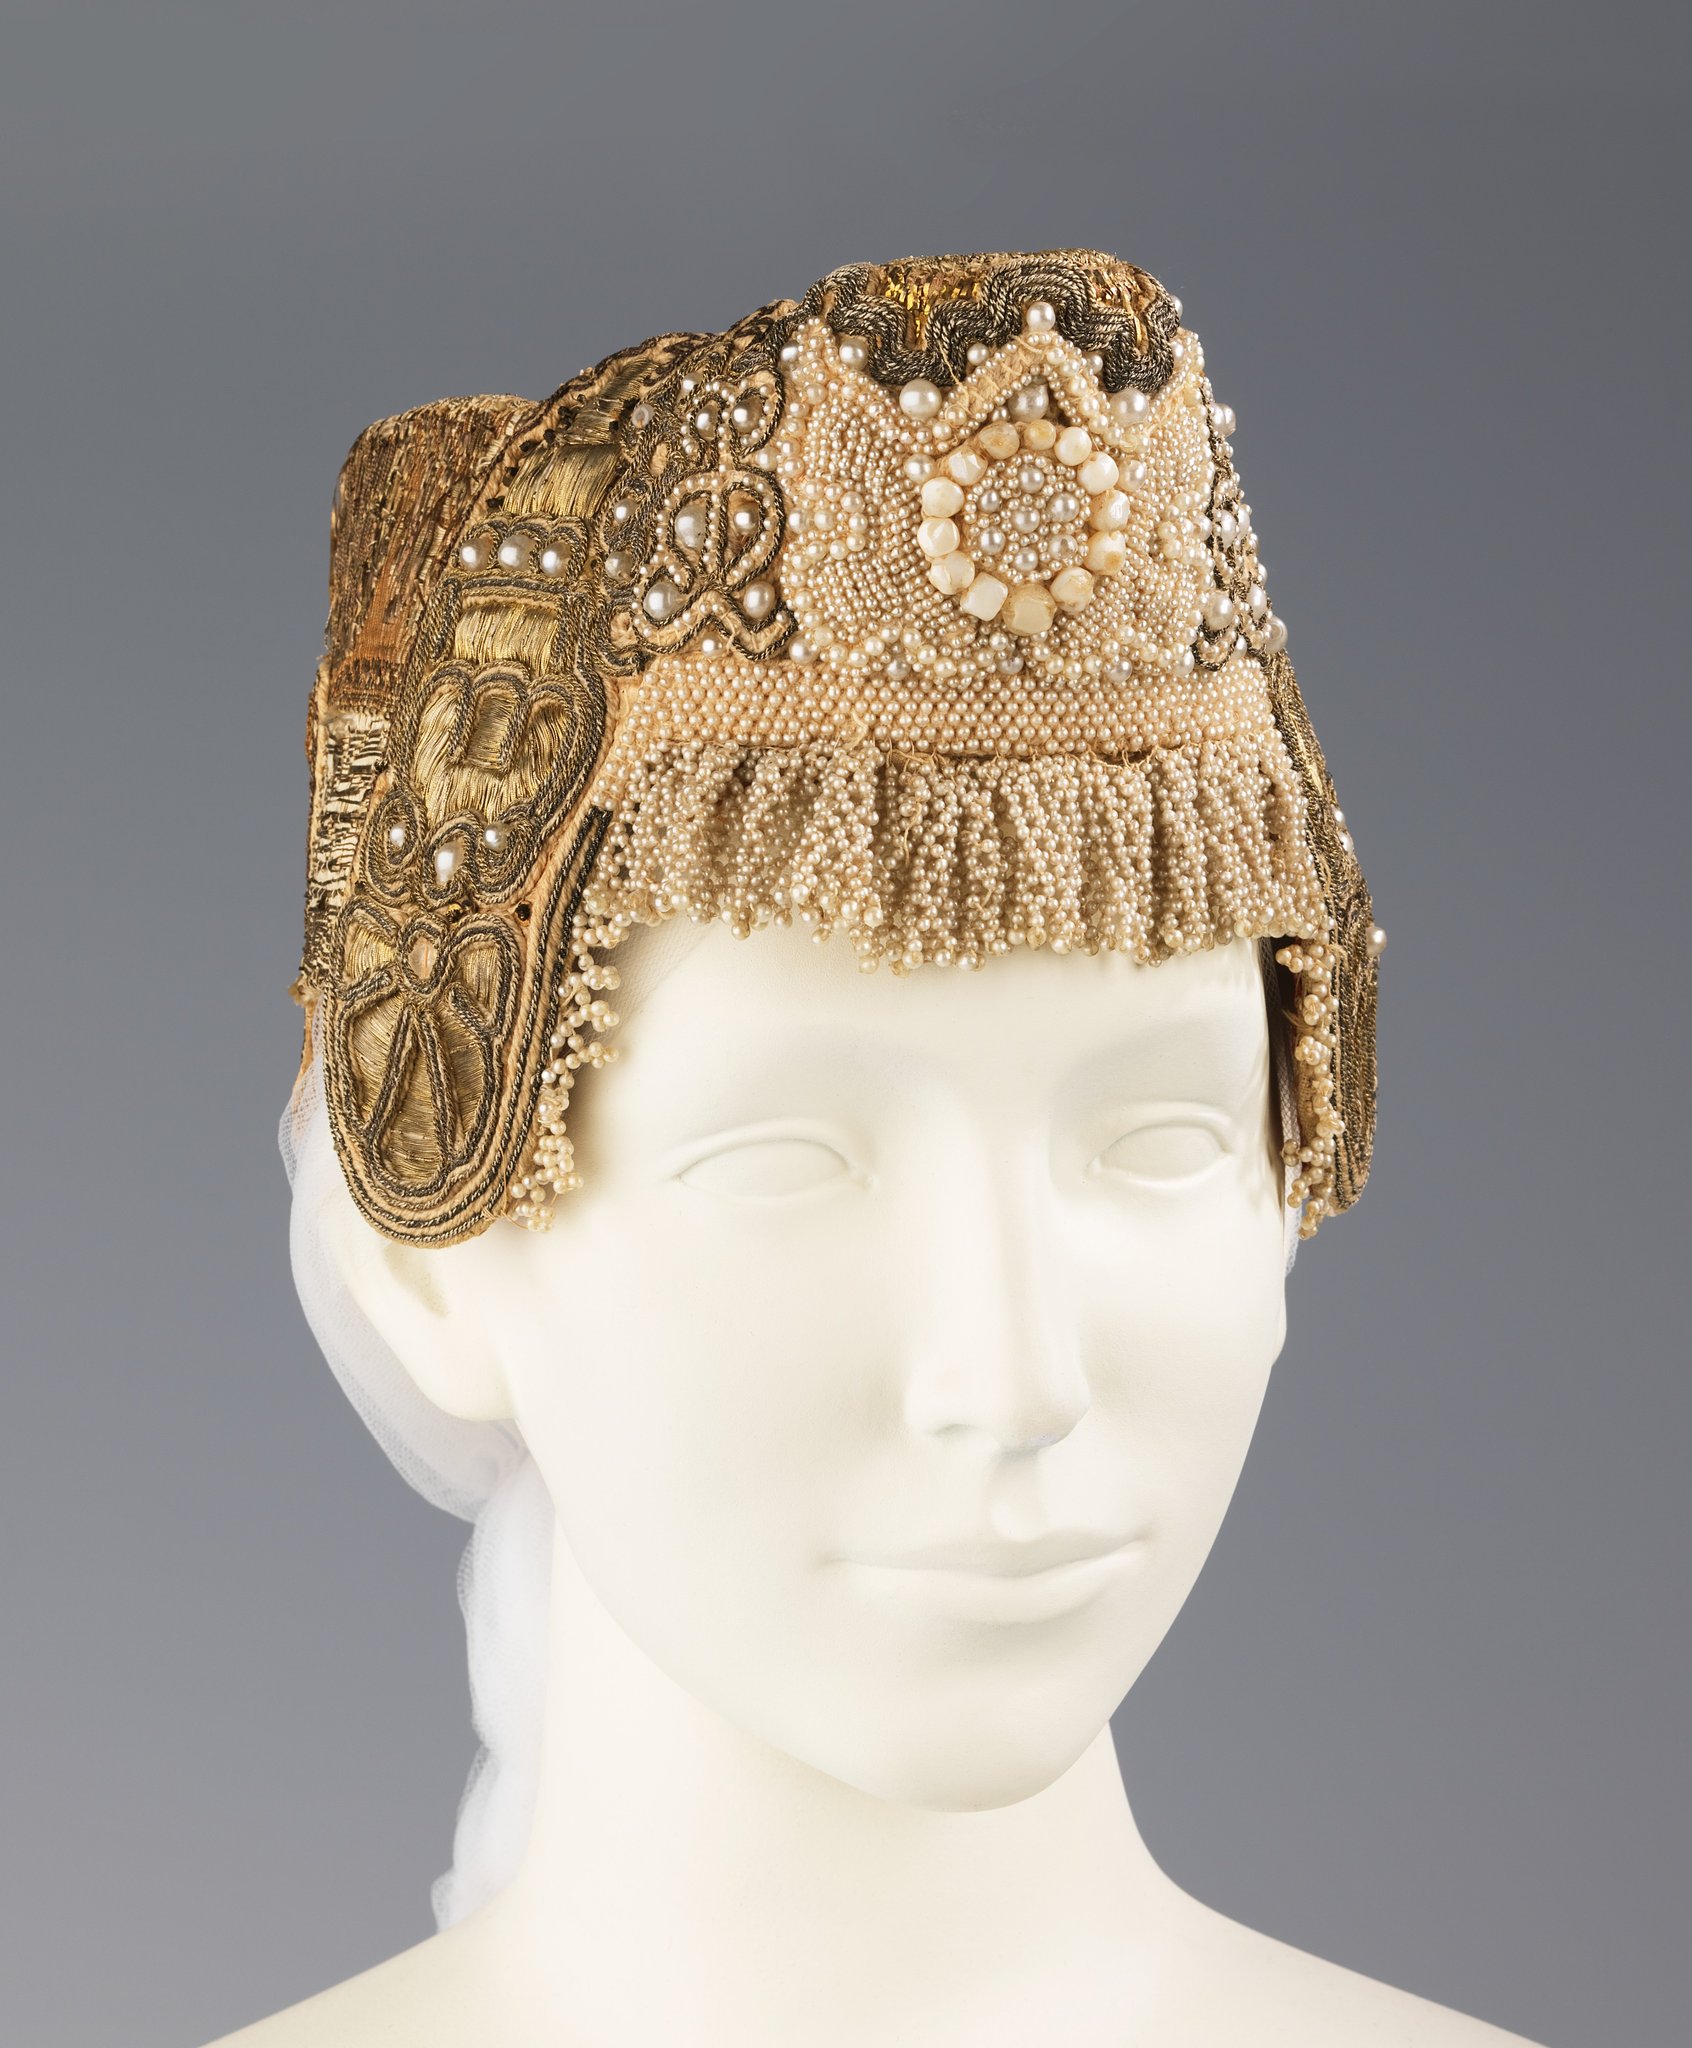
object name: headdress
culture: russian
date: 1801-1833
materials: cotton, metal, paper, pearl